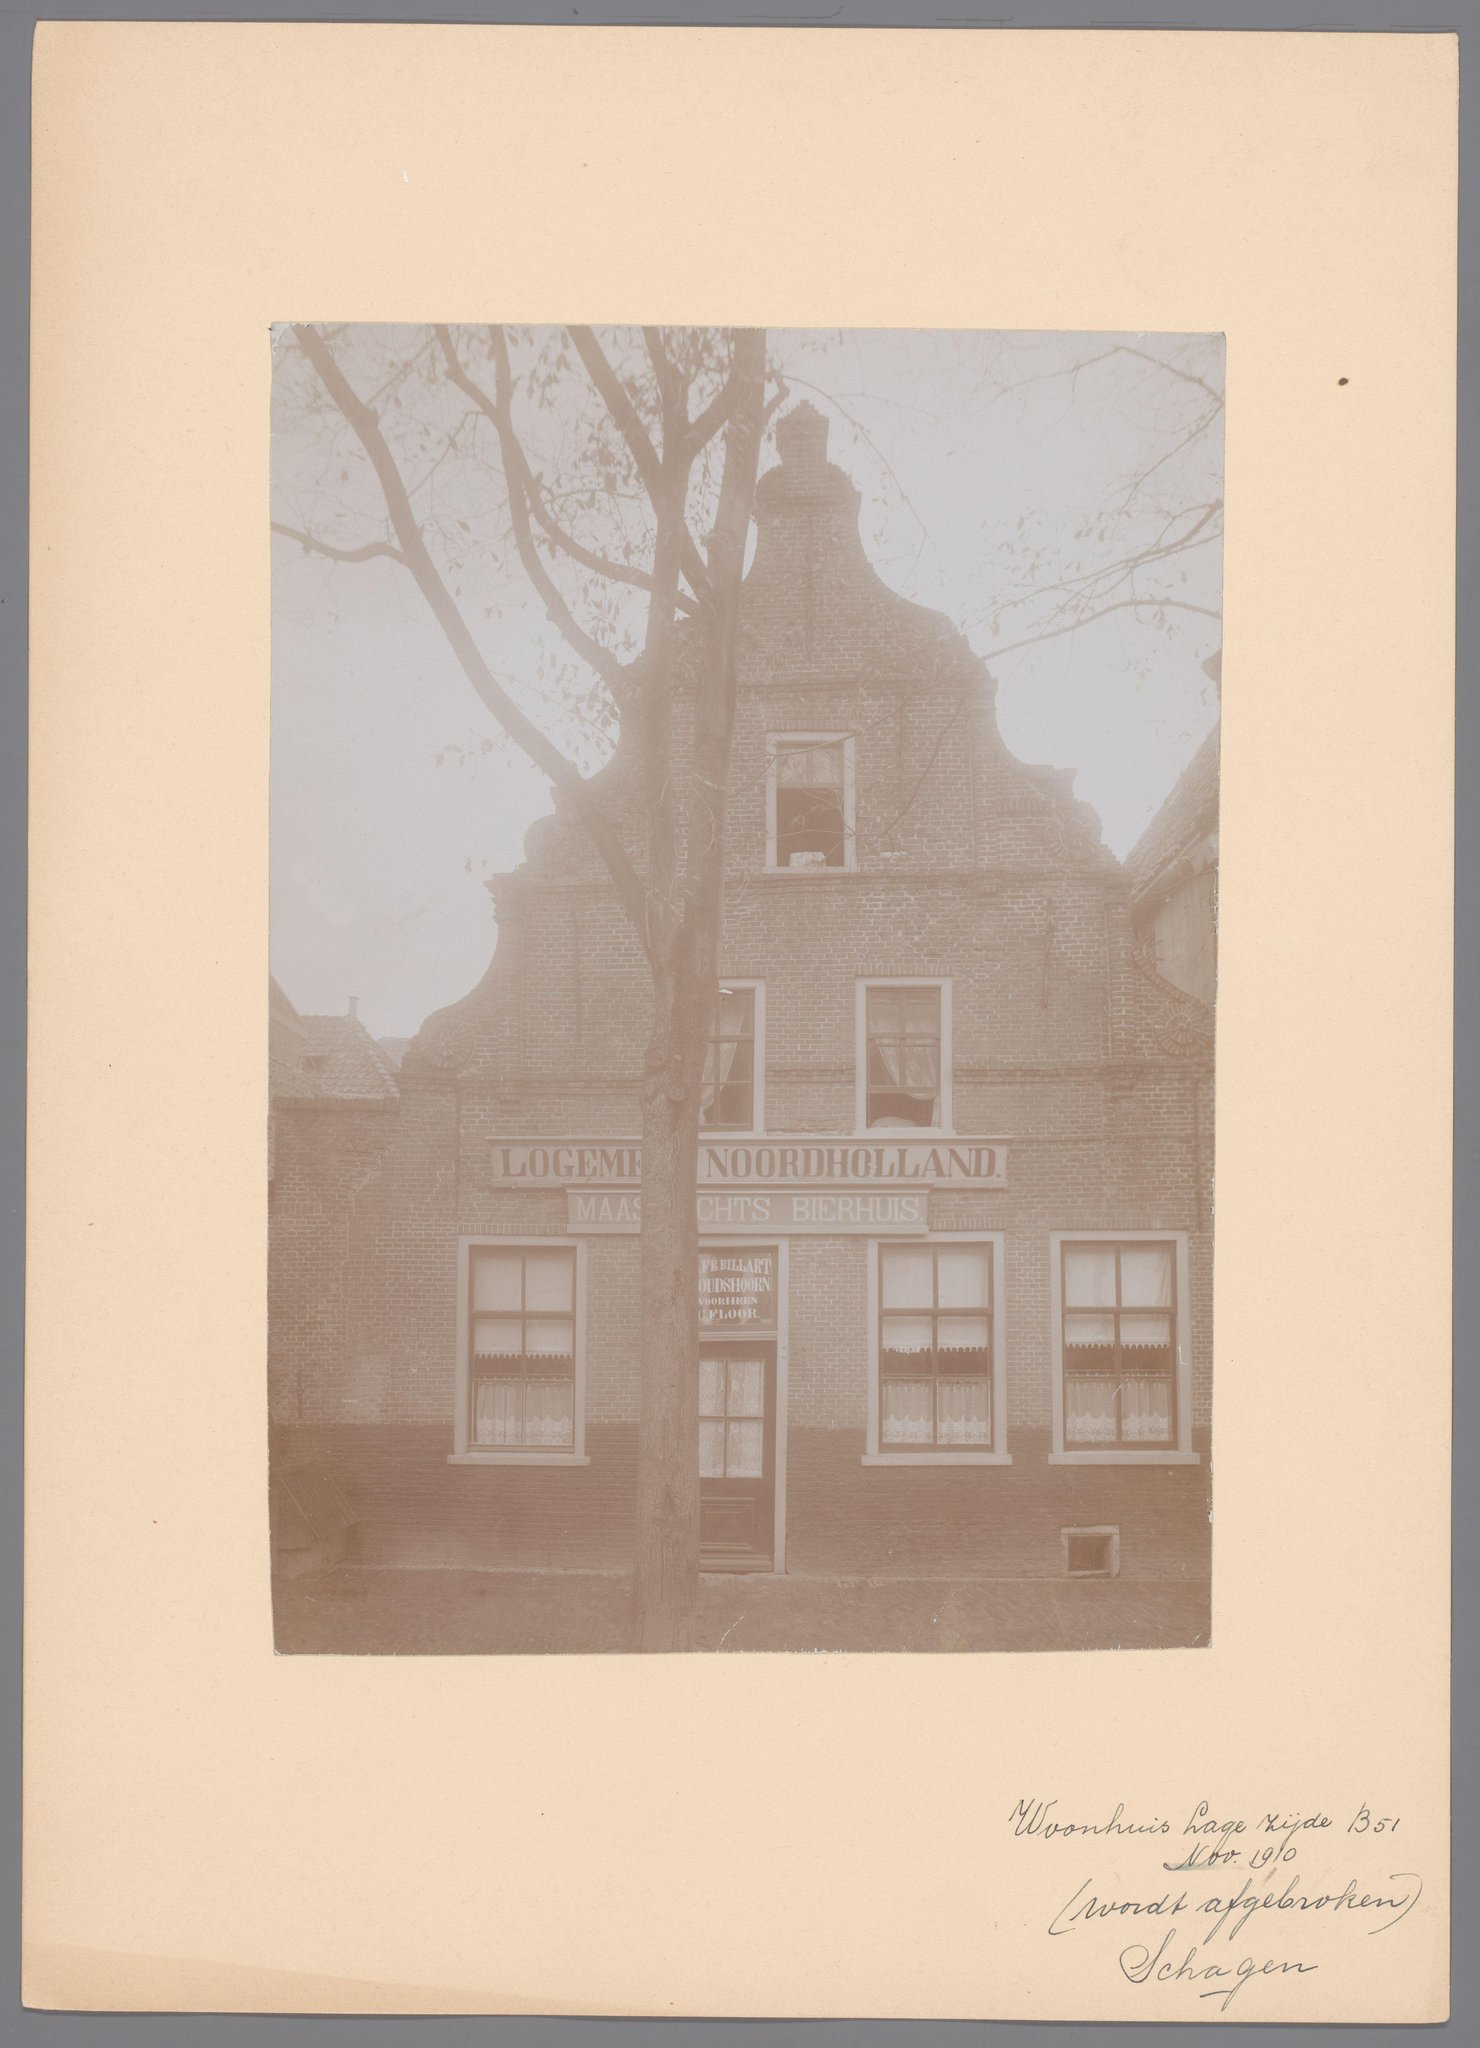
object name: photograph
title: Pand op Lagezijde B51 te Schagen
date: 1910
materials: cardboard, photographic support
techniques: collodion silver print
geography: schagen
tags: urban housing, hotel, hostelry, inn, schagen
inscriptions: annotation: ‘Woonhuis Lage Zijde B51/ Nov. 1910/ (wordt afgebroken)/ Schagen’